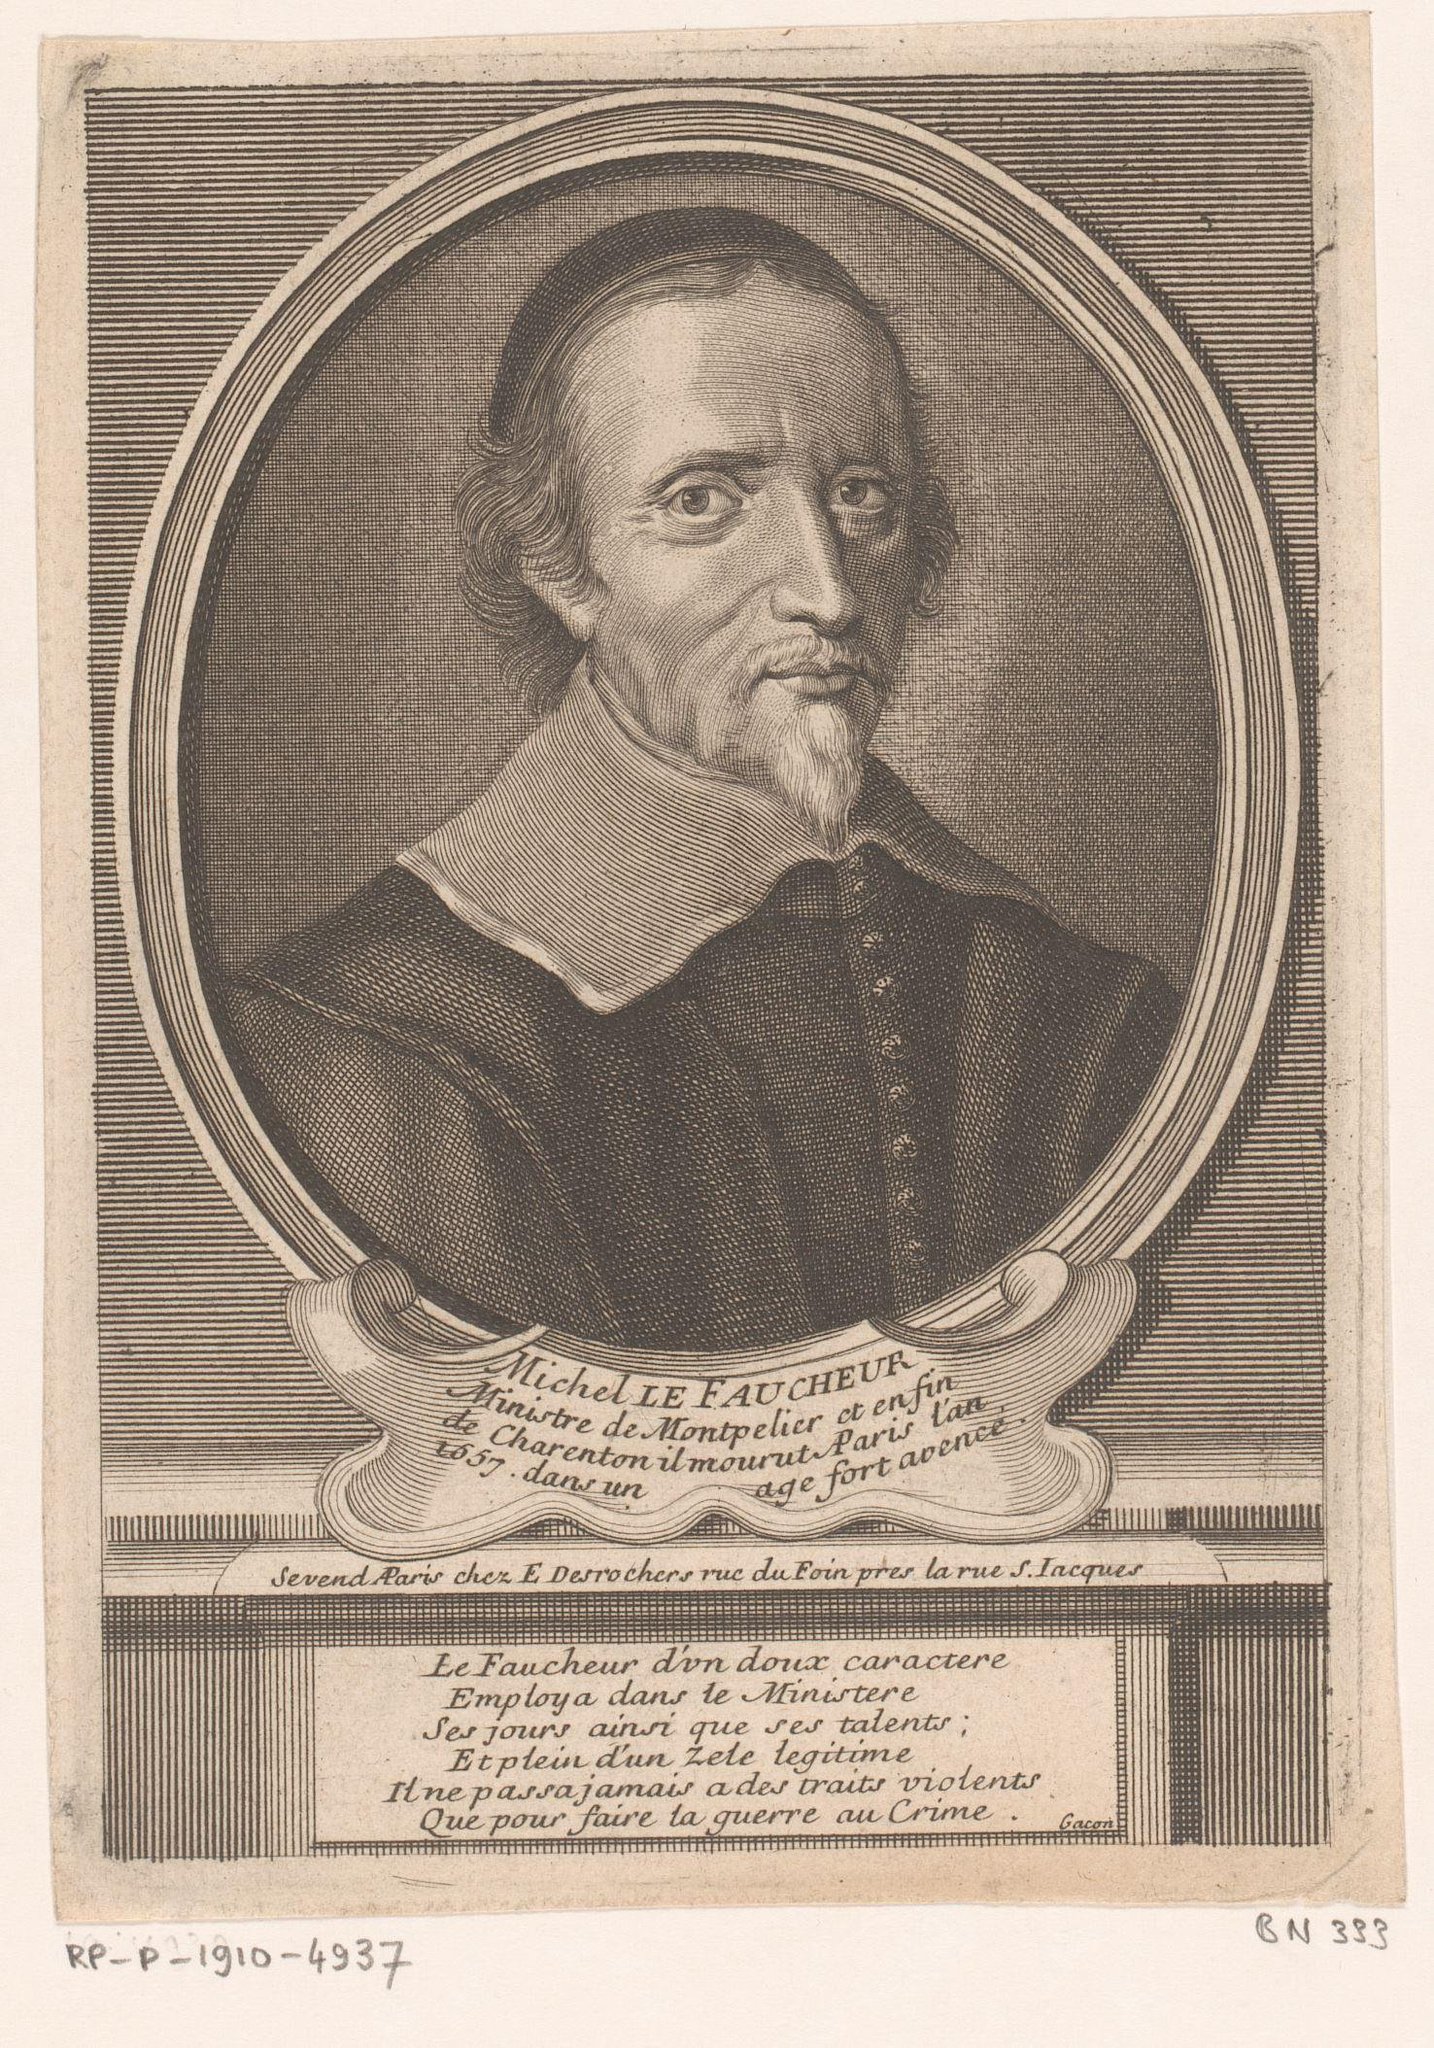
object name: print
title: Recueil de portraits (...)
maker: étienne desrochers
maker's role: print maker, publisher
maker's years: 1668-1741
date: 1726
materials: paper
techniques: engraving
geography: paris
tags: paris, historical persons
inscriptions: collector's mark: Lugt 2228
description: Behoort waarschijnlijk tot een serie portretten, grotendeels door Etienne Desrochers, getiteld: 'Recueil de portraits de personnes qui se sont distinguées tant dans les Armes que dans Belles-Lettres et les Arts, comme aussi la famille royale de France et autres cours étrangères'. De serie werd initieel uitgegeven door Desrochers en aangekondigd in 'Mercure' in mei 1726, p. 985. Echter was Desrochers reeds enkele jaren eerder begonnen met het uitgeven van de serie. Na de dood van Desrochers werd de serie voortgezet door Gilles Edme Petit. Een latere staat werd uitgegeven door Jean François Daumont in Parijs.